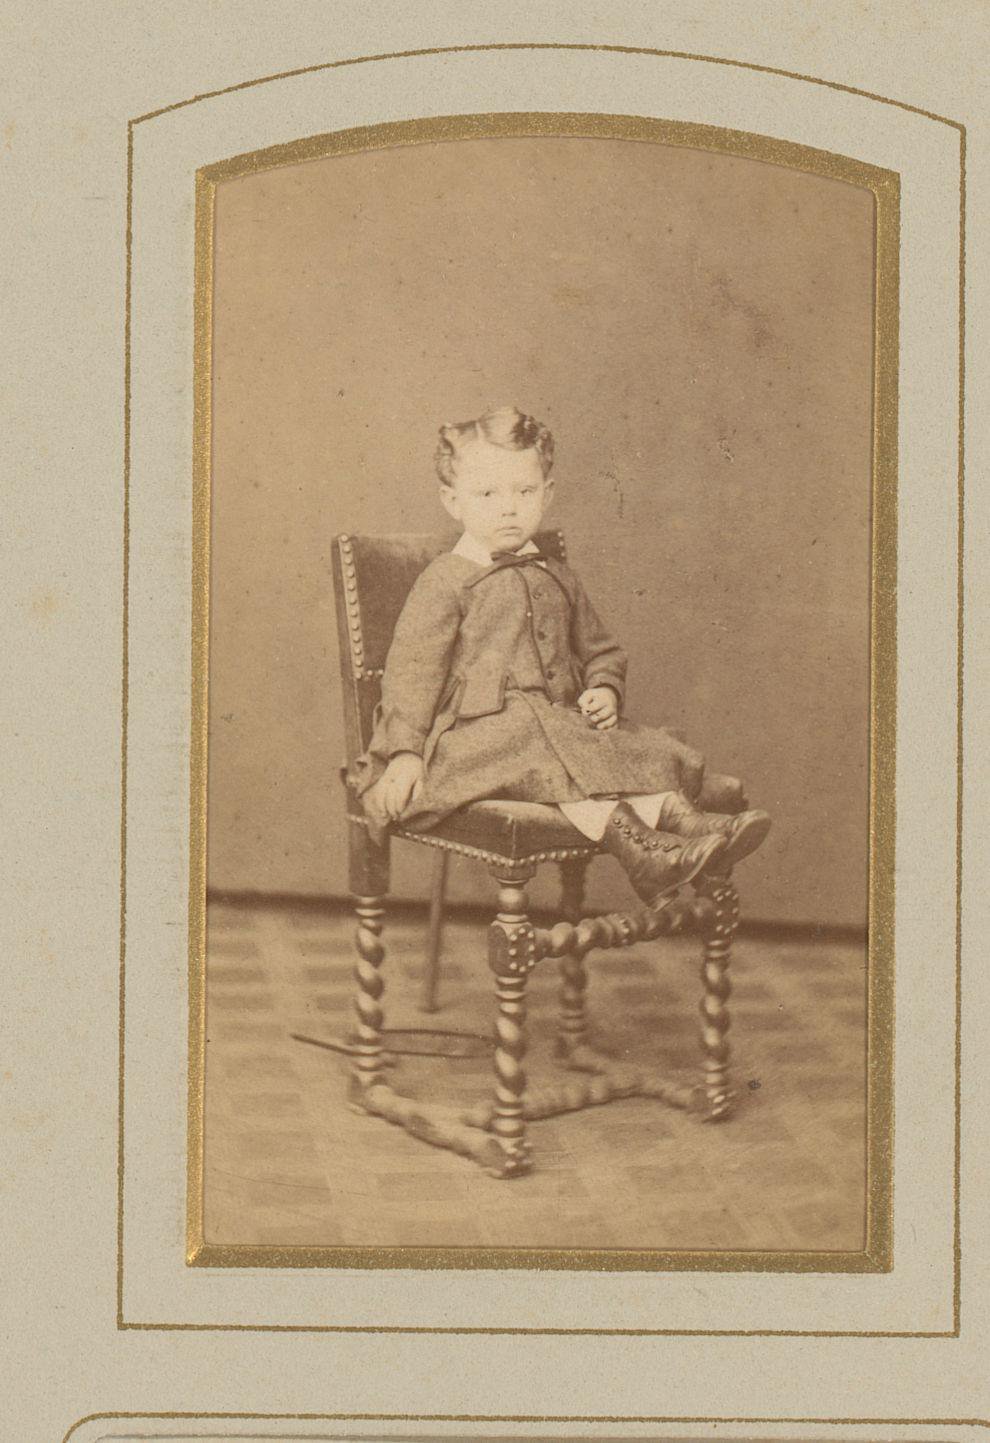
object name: carte de visite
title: Portret van een jongen, zittend op een stoel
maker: charles de trez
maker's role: painter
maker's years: 1822-1899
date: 1860-1882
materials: cardboard, photographic support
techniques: albumen print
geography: brussels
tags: historical persons, toddler (male), chair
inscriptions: inscription: ‘CH. DE TREZ/ Photographe/ rue du Pont-Neuf/ No 1./ Bruxelles.’